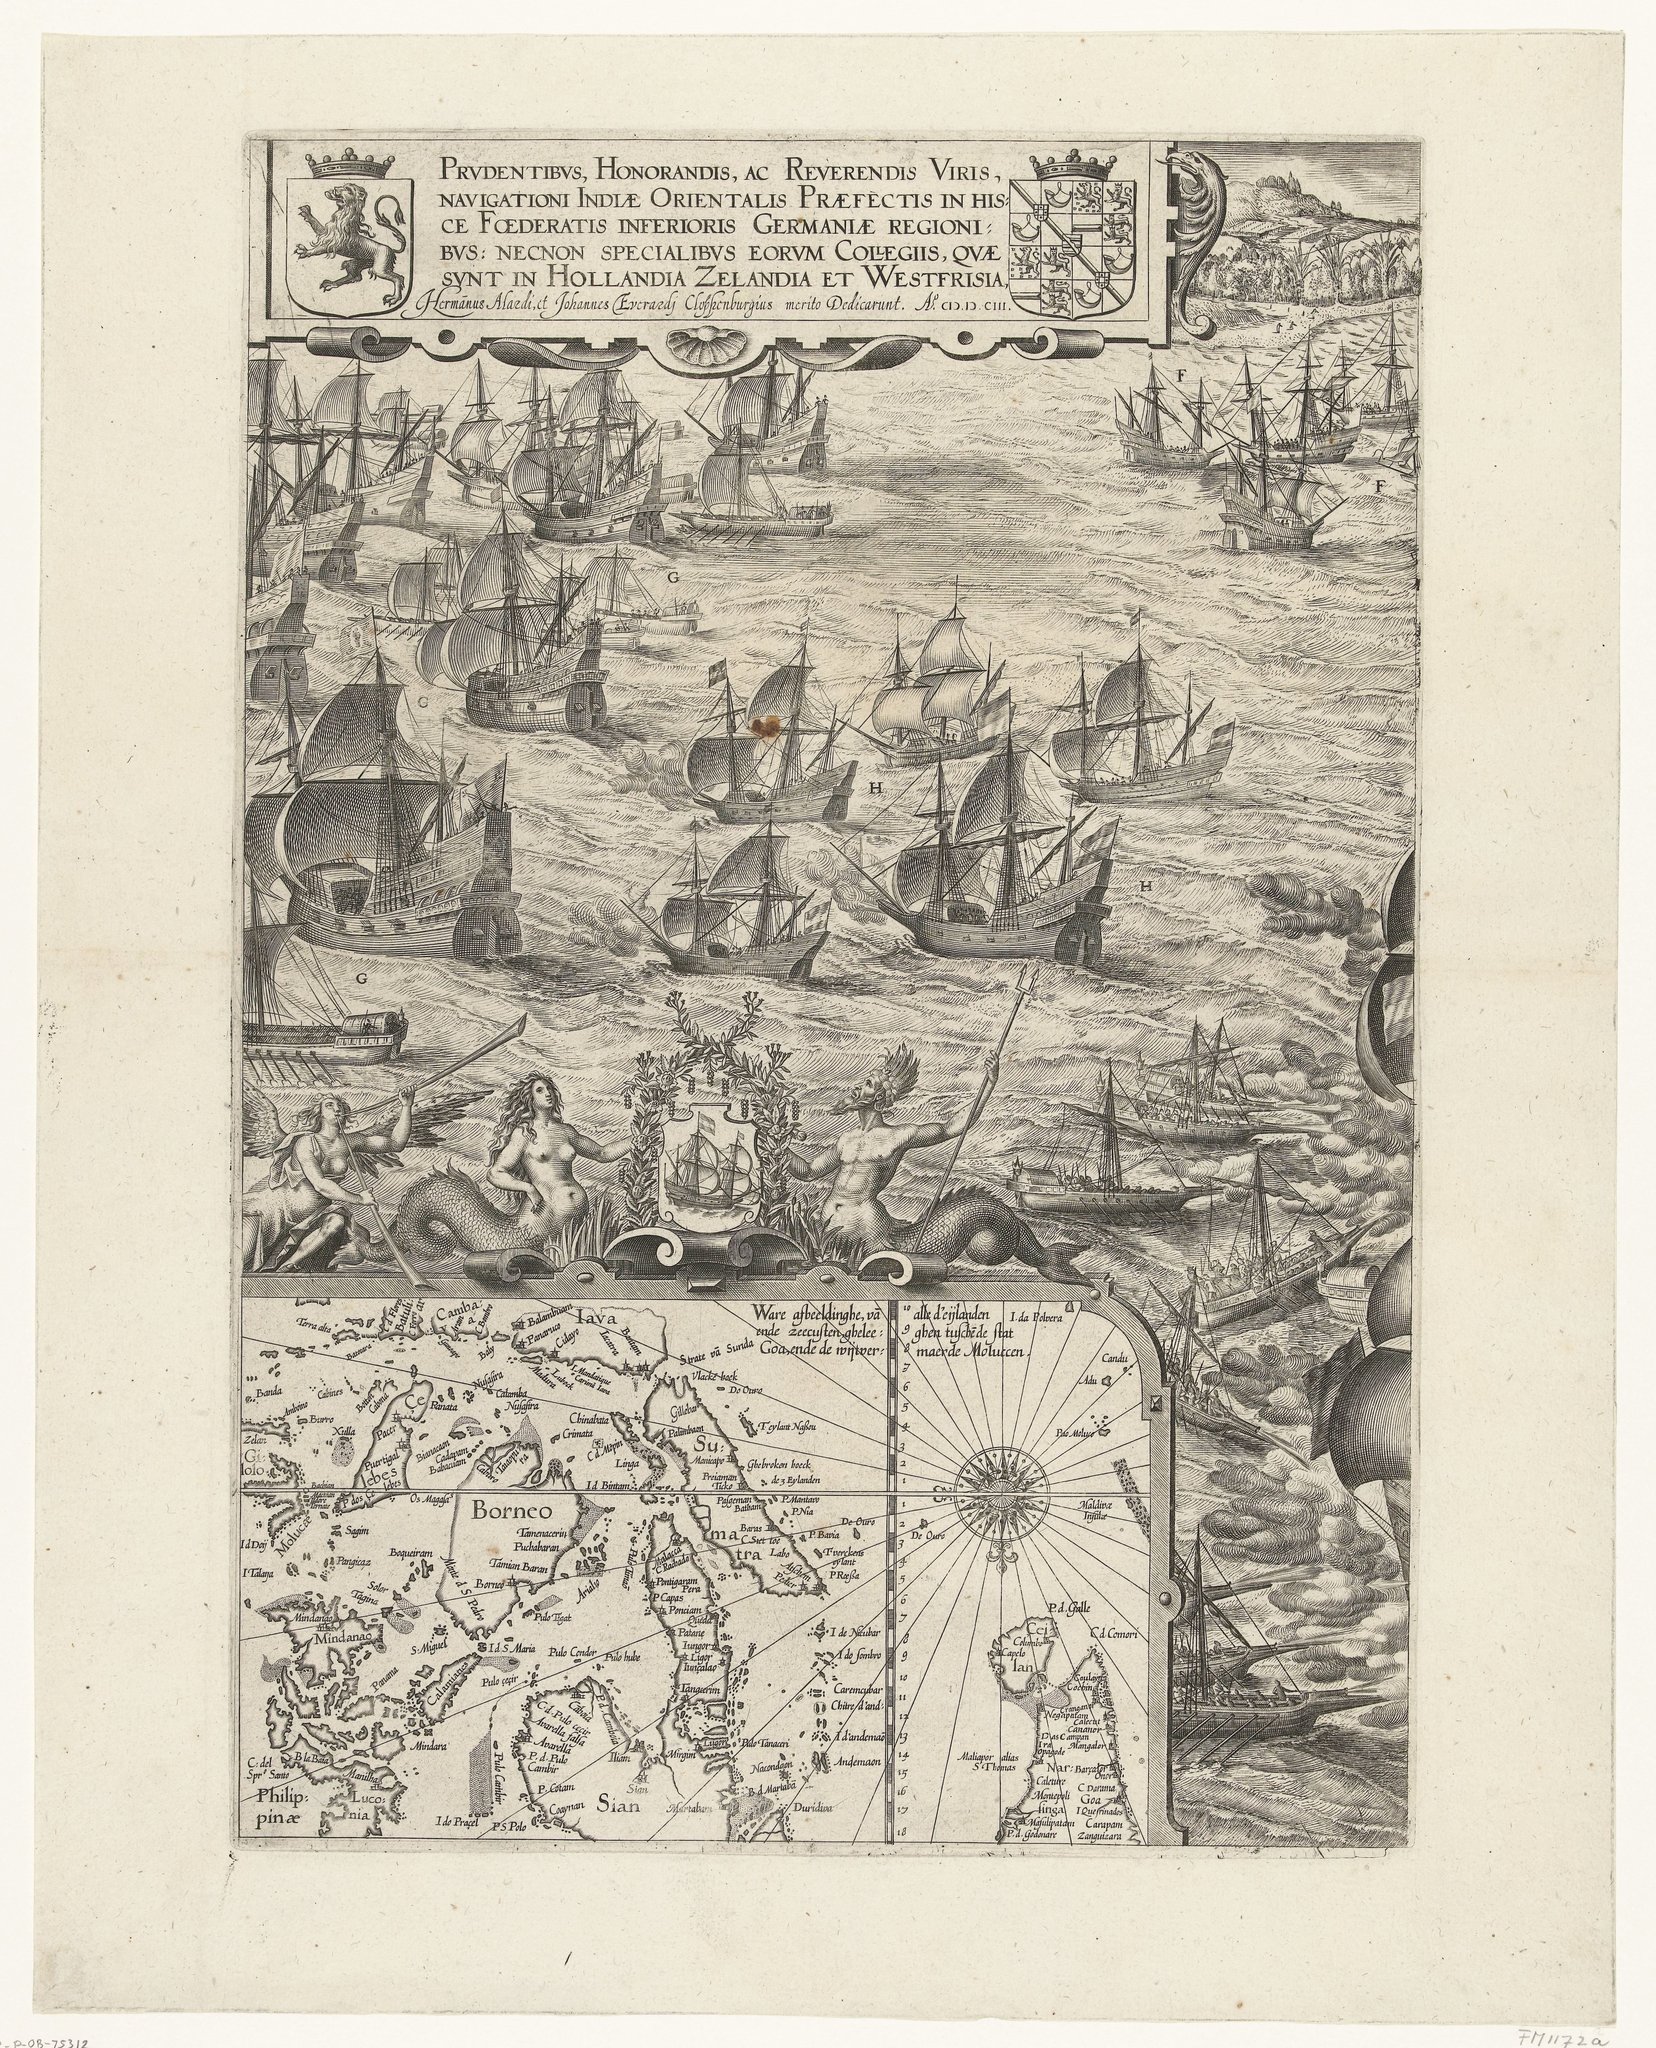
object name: print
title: Warachtighe Afbeeldinghe vanden wonderbaren ende ghedenckwaerdighen Scheeps-strijdt ende slagh / welcke in Oost-Indien / int ghesichte van de vermaerde Coopstadt Bantam gheschiet is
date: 1603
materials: paper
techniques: engraving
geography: amsterdam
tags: maps of separate countries or regions, battle (+ naval force), sri lanka, indonesia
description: Overwinning van de admiraal Wolfert Hermansz met vijf schepen op de Portugese vloot van dertig schepen in de zeeslag voor Bantam, 25-30 december 1601. Grote voorstelling op drie bladen met bijbehorende tekstbladen, linkerblad. Bovenaan een cartouche met de opdracht in het Latijn, een provinciewapen (waarschijnlijk Holland) en het wapen van Maurits. Onderaan een kaartje van een deel van de eilanden in de Indonesische archipel en Ceylon.